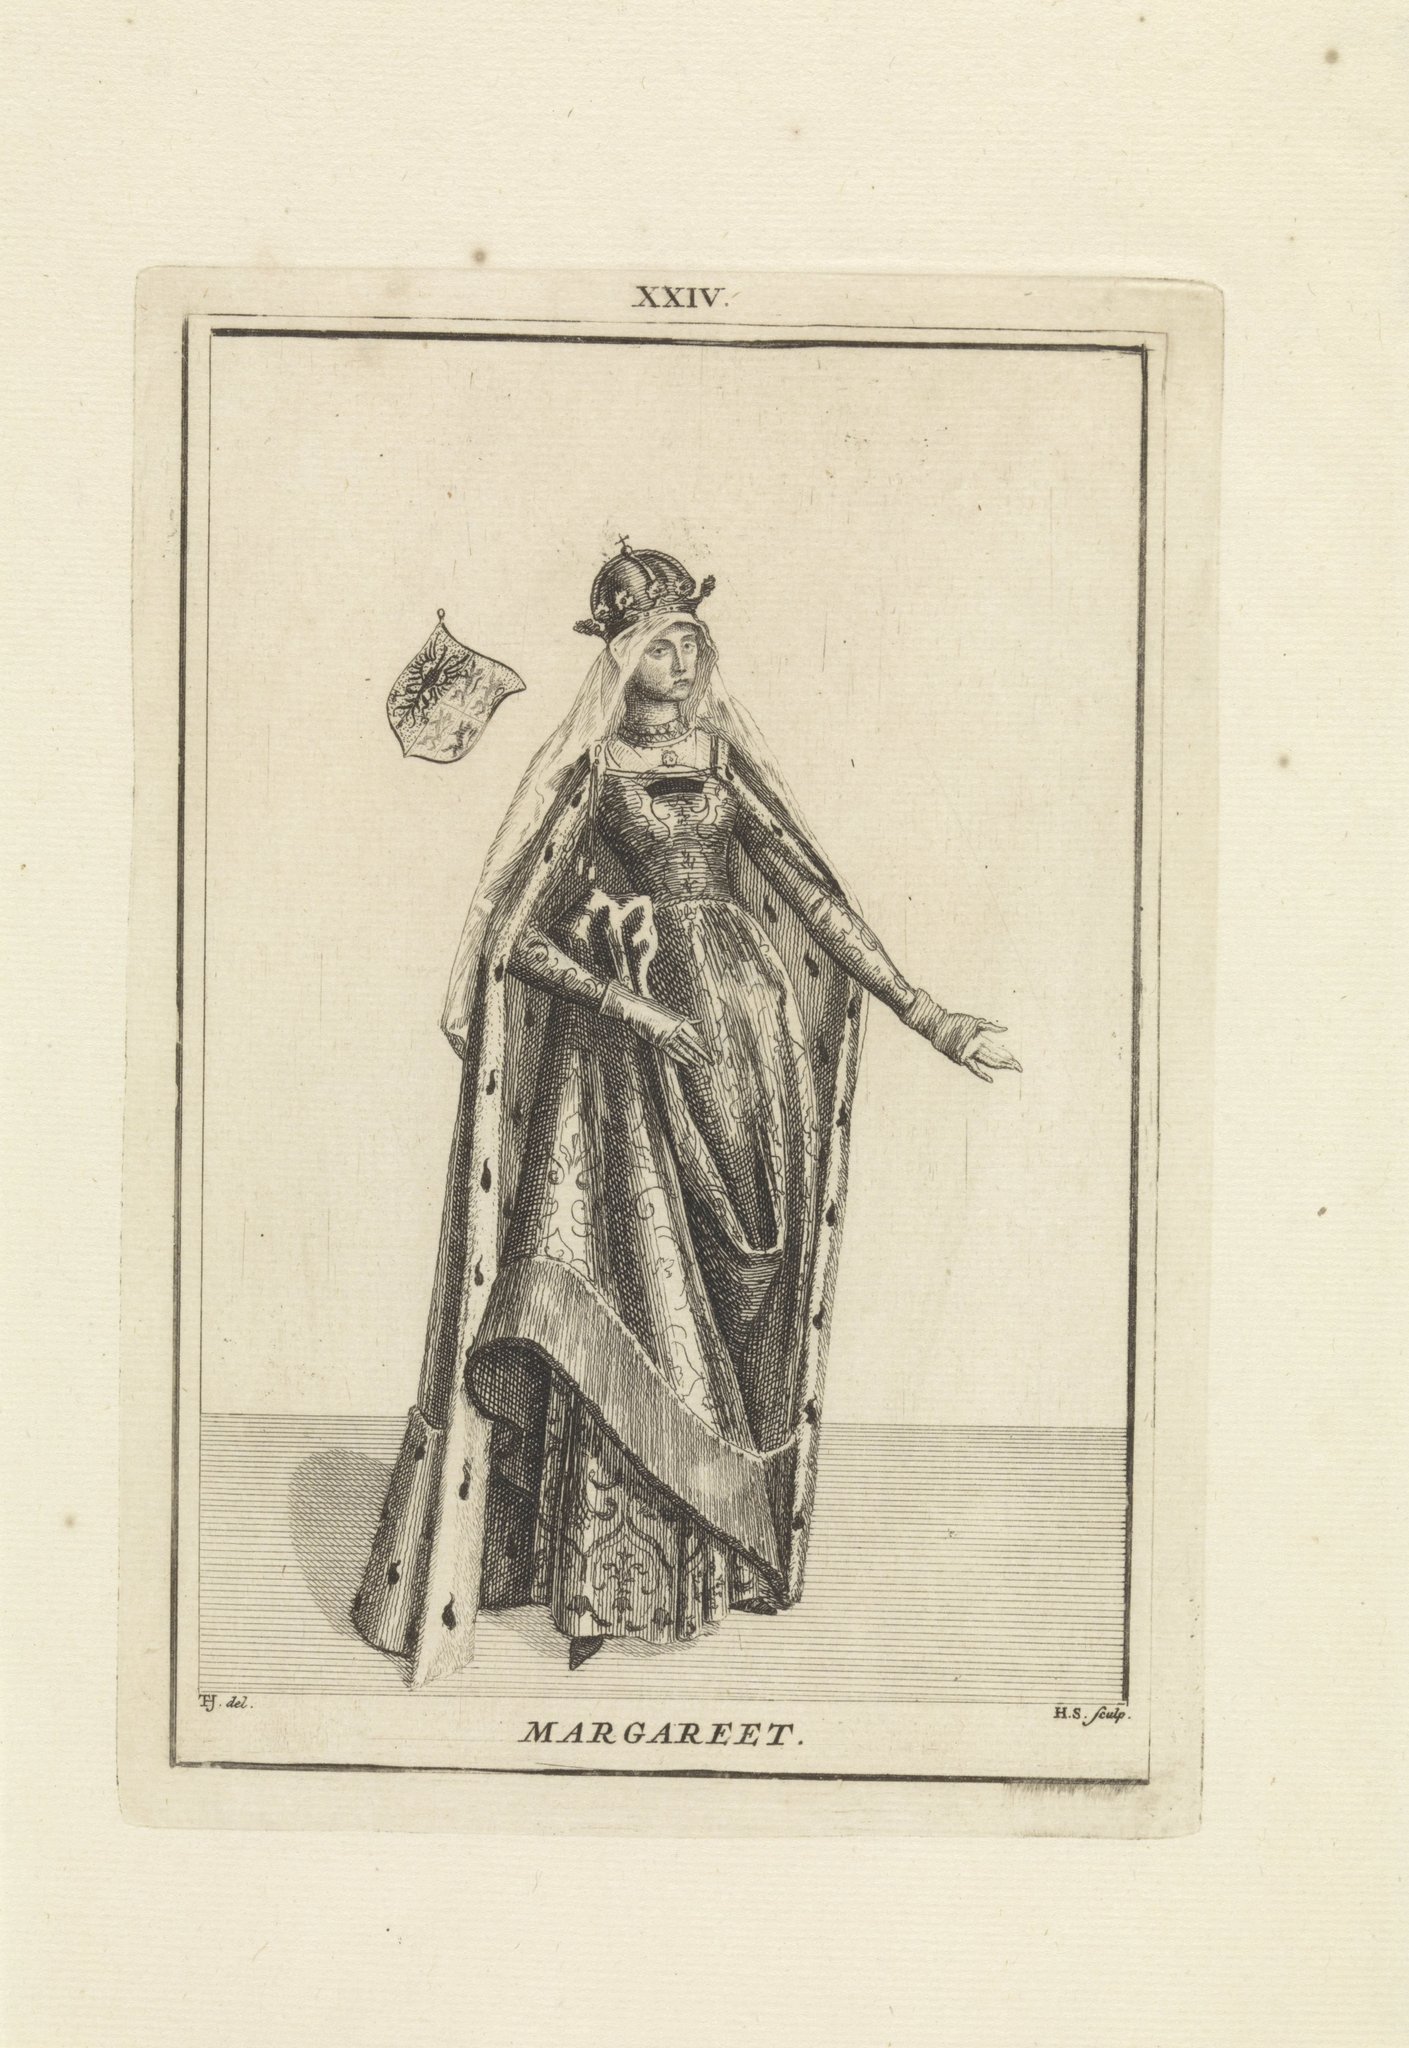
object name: book illustration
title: Portret van Margaretha van Beieren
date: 1745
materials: paper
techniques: etching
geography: haarlem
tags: nobility and patriciate; chivalry, knighthood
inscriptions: collector's mark: Lugt 2228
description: Boekillustratie voor: Langendyk, Pieter. De Graaven van Holland, in jaardichten beschreven door Pieter Langendyk. Verykt met alle de beeldtenissen dier prinsen, naauwkeurig getekend naar de echte aloude tafereelen of de zaal van't raadhuis der stad Haarlem. Haarlem: J. Bosch, 1745.